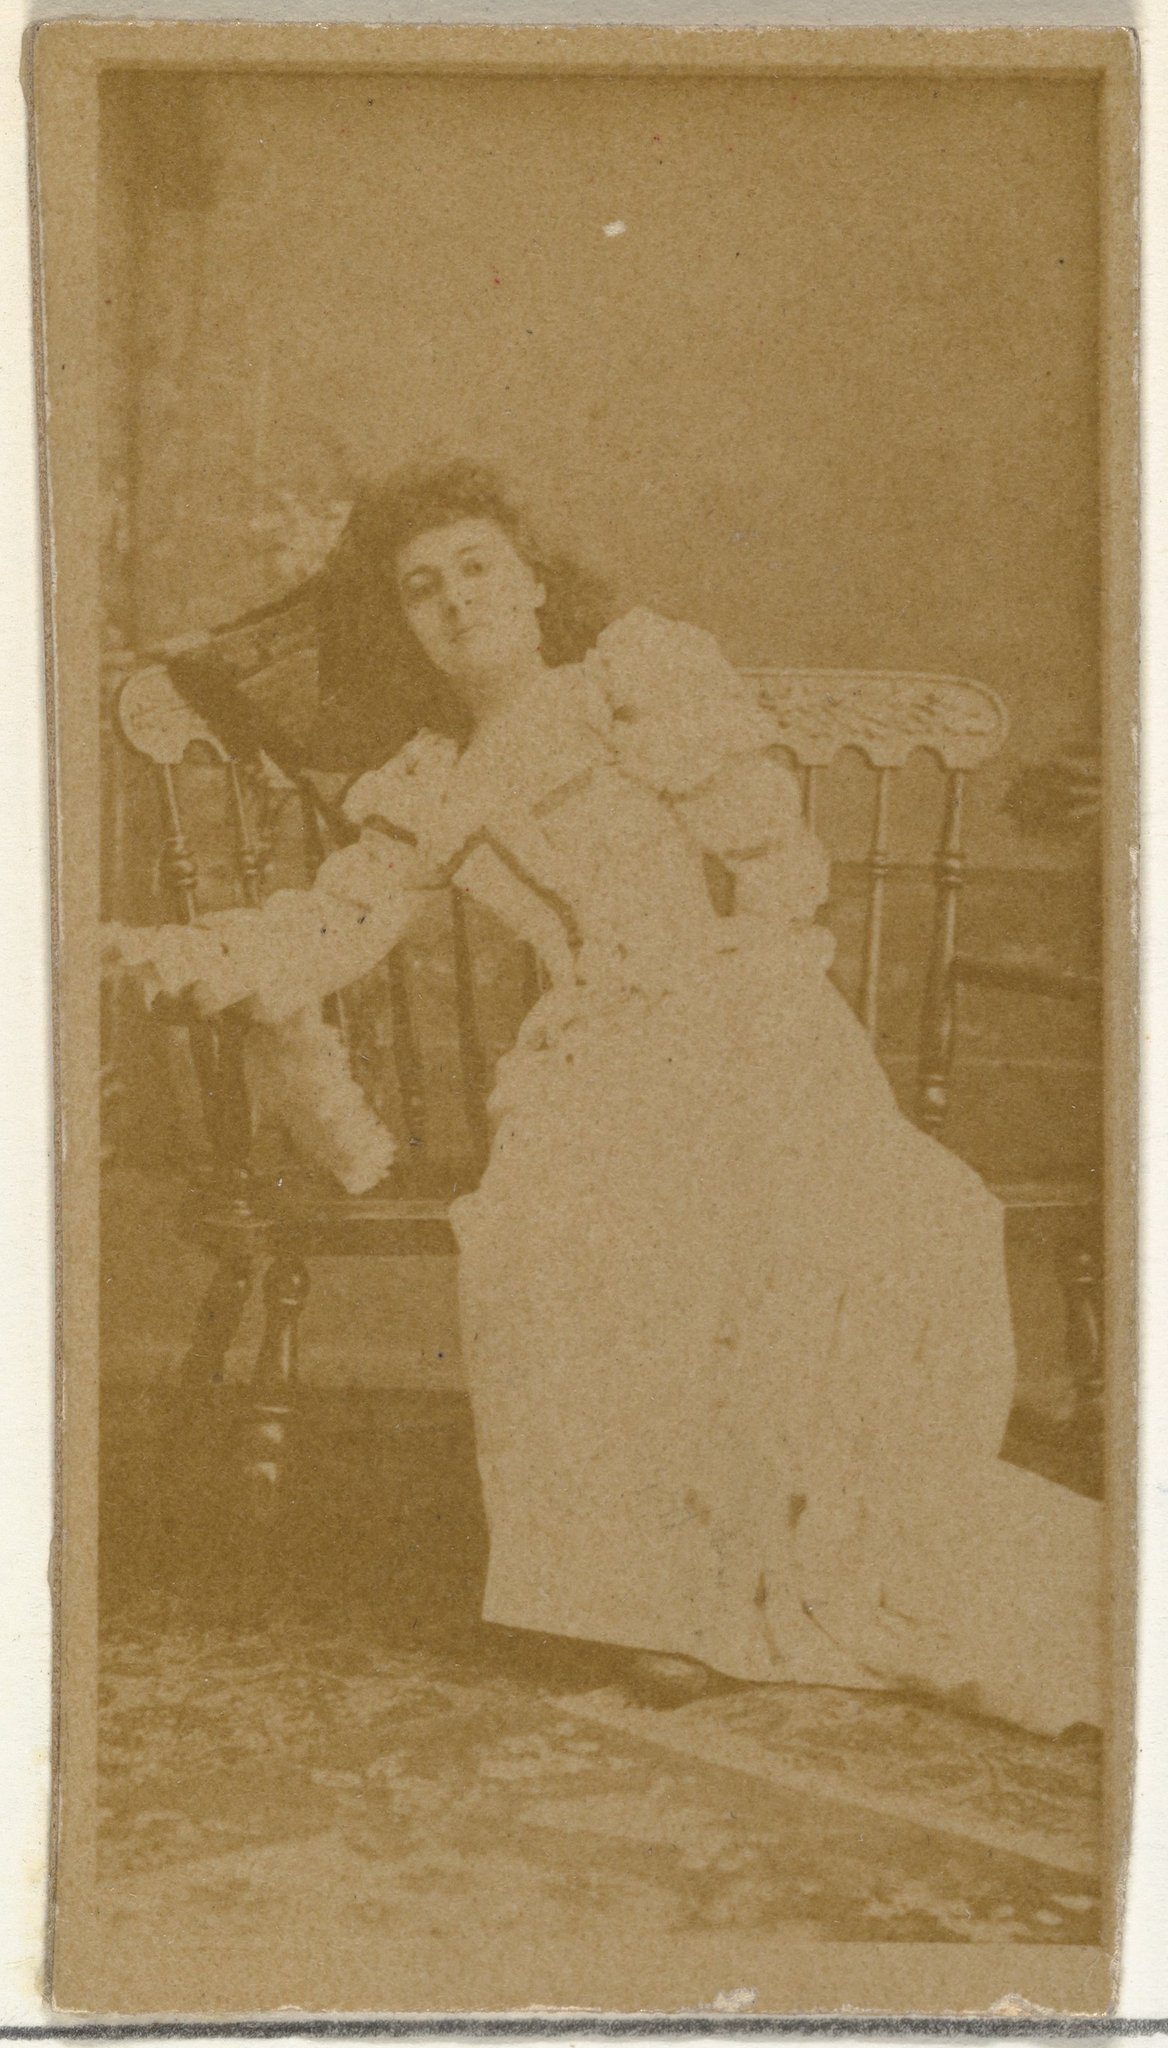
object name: photograph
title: [Actress reclining on wooden seat], from the Actors and Actresses series (N145-8) issued by Duke Sons & Co. to promote Duke Cigarettes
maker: w. duke, sons & co.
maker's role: publisher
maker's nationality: american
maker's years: 1870-1920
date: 1891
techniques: albumen silver print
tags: portraits,women,actresses